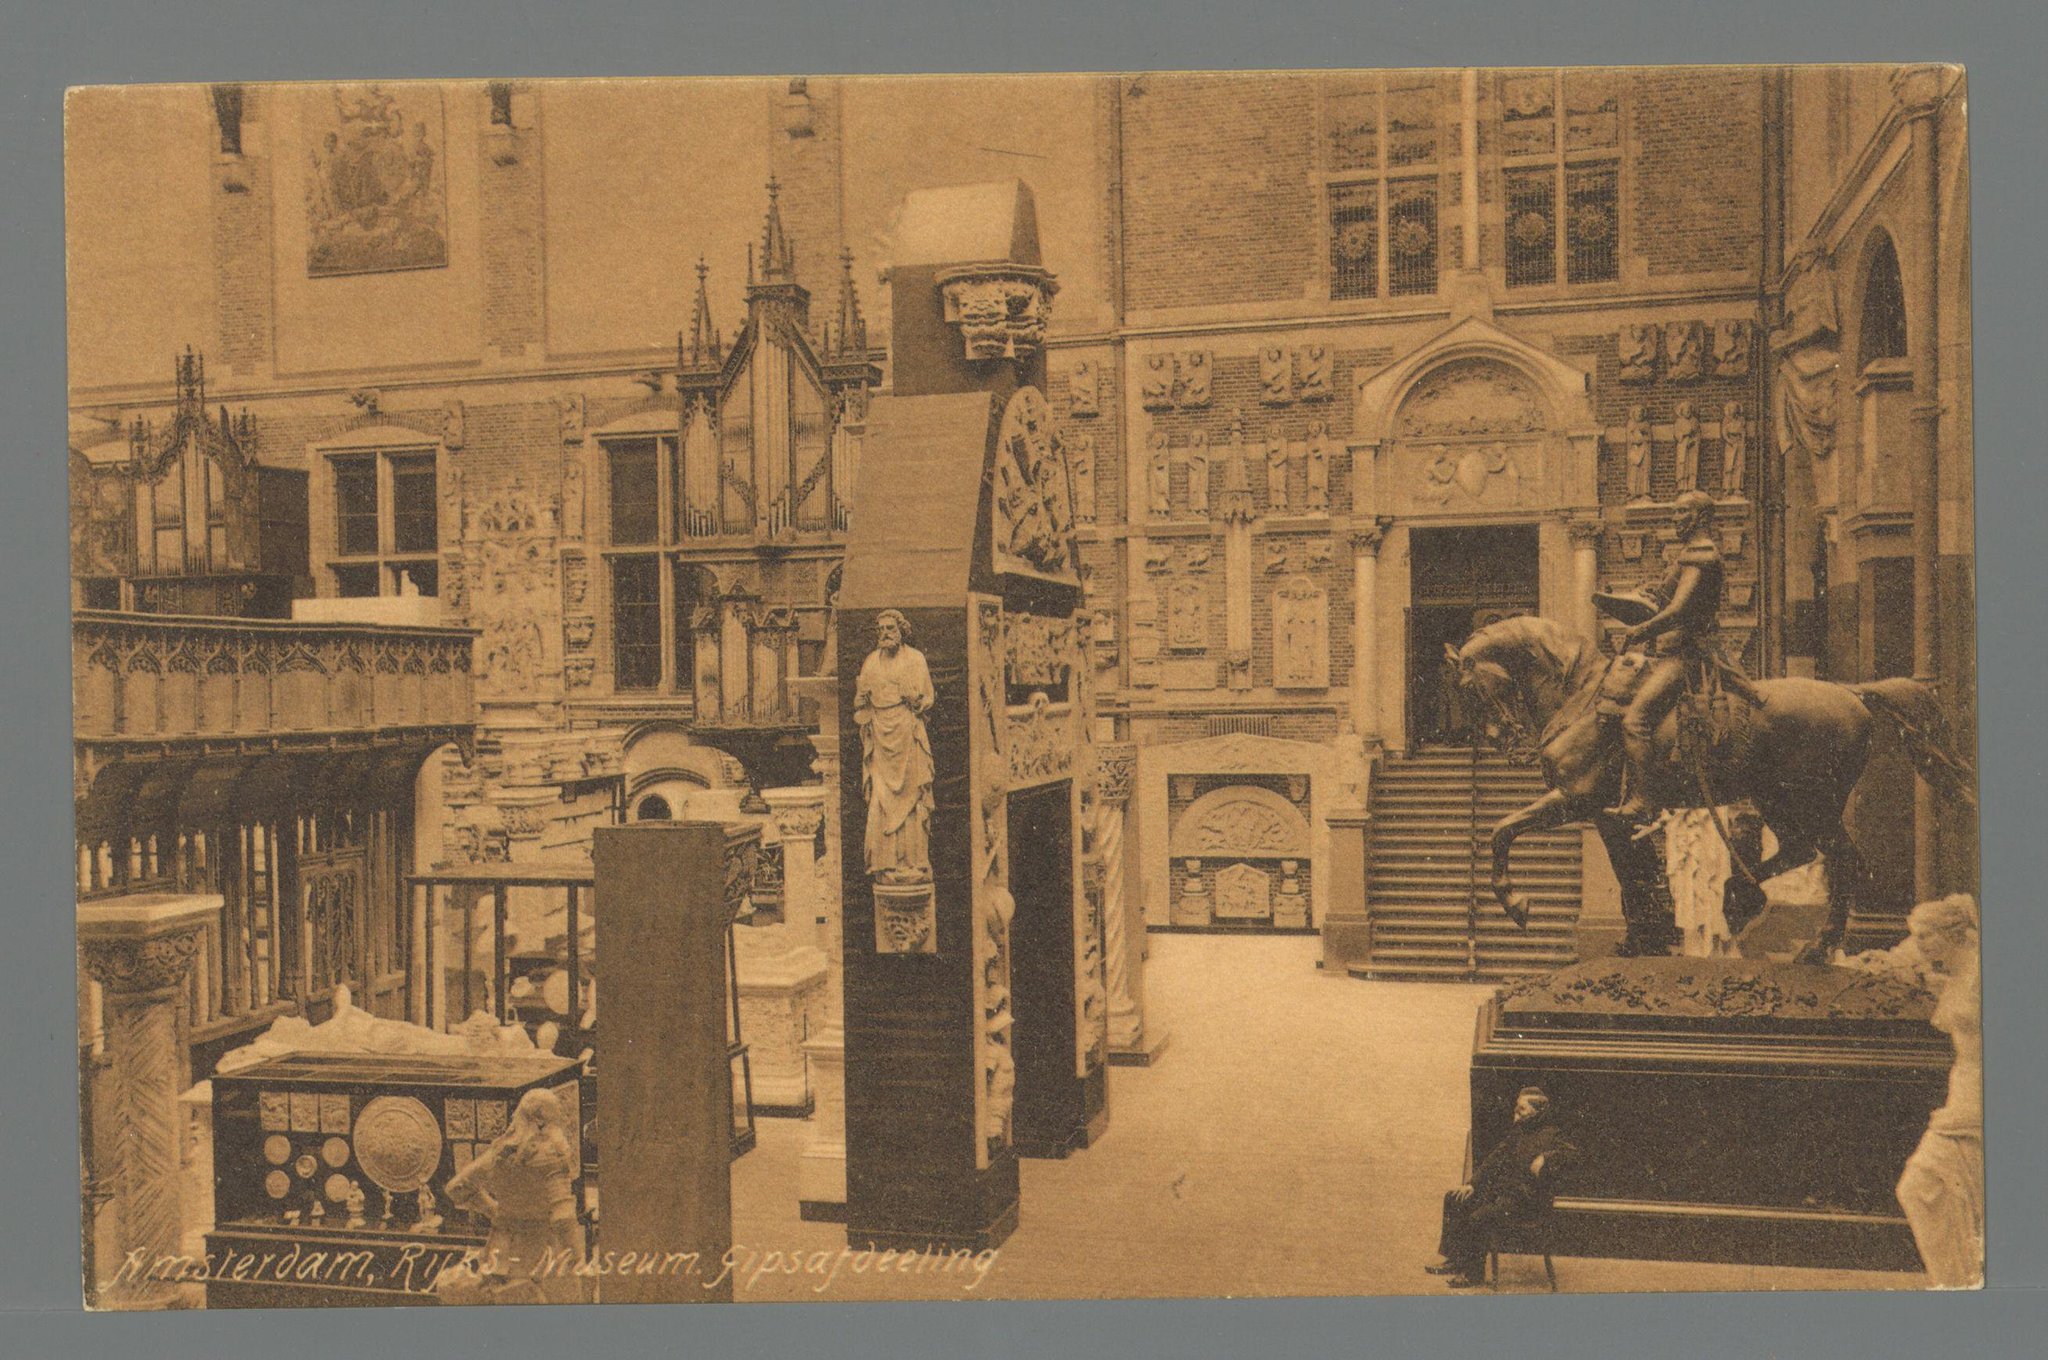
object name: photomechanical print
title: Amsterdam, Rijks-Museum. Gipsafdeeling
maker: Anonymous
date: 1906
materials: cardboard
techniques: photograph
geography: leipzig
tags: piece of sculpture, reproduction of a piece of sculpture, permanent exhibition, museum